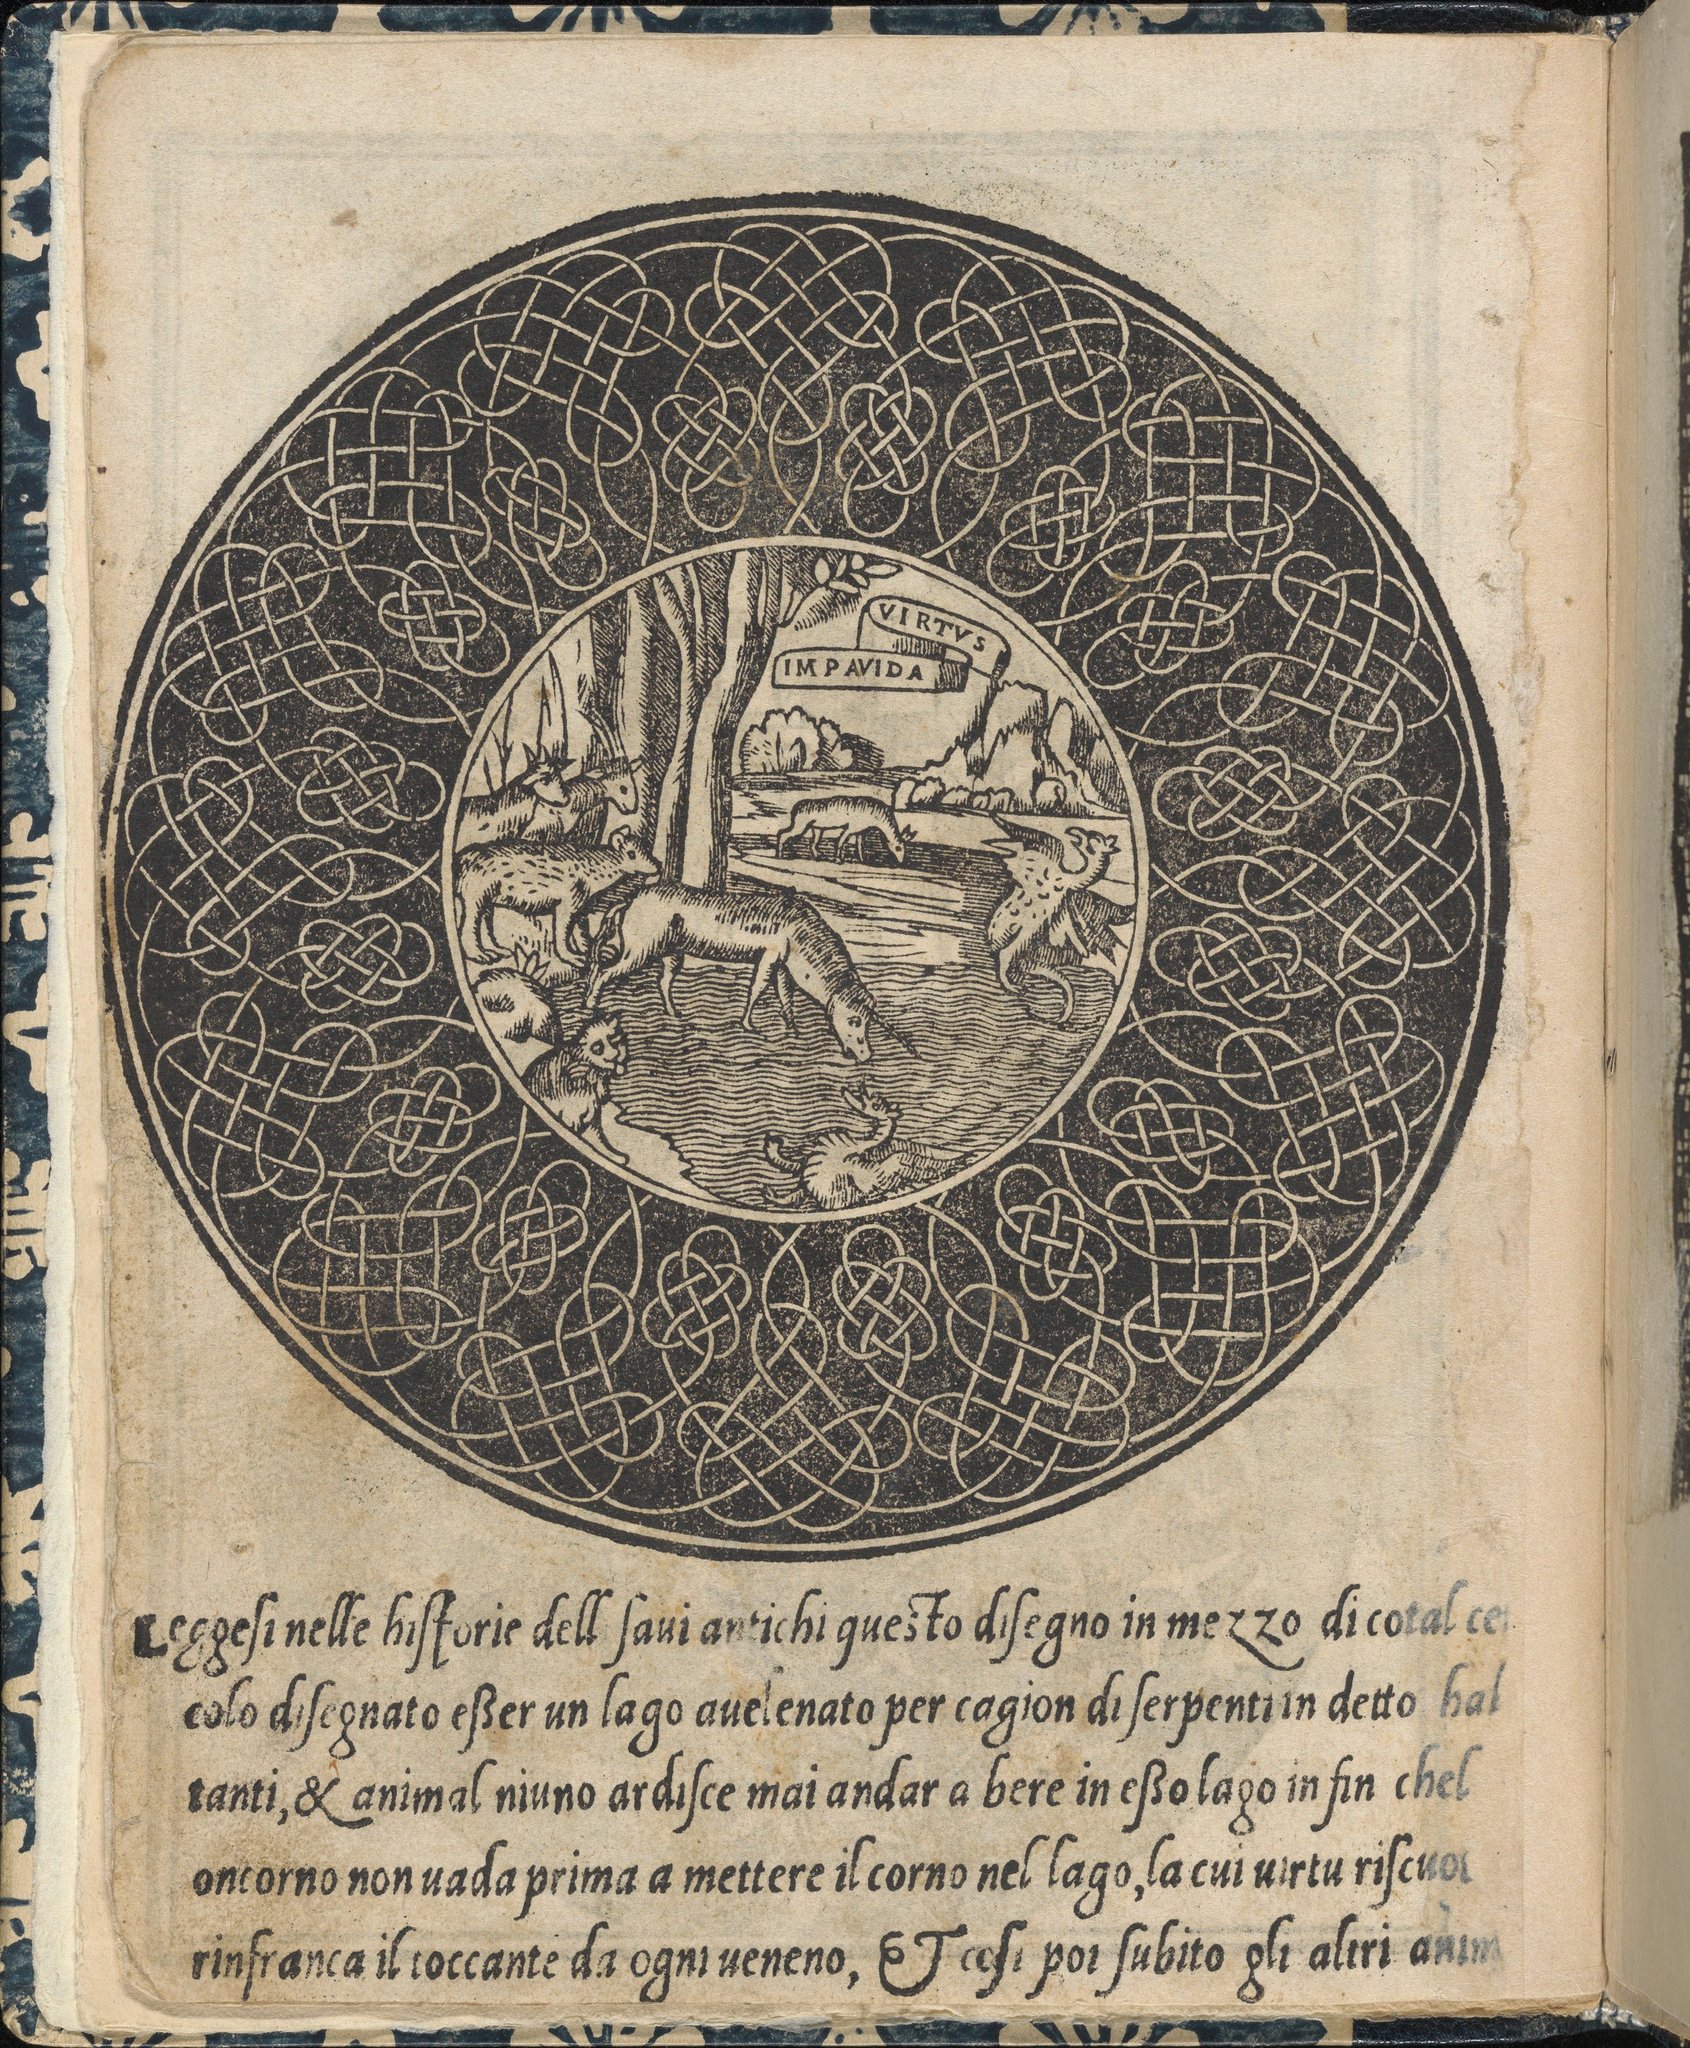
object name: book print ornament architecture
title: Essempio di recammi, page 4 (verso)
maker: giovanni antonio tagliente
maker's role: author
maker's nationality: italian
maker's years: 1465-1528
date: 1530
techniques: woodcut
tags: animals,unicorns